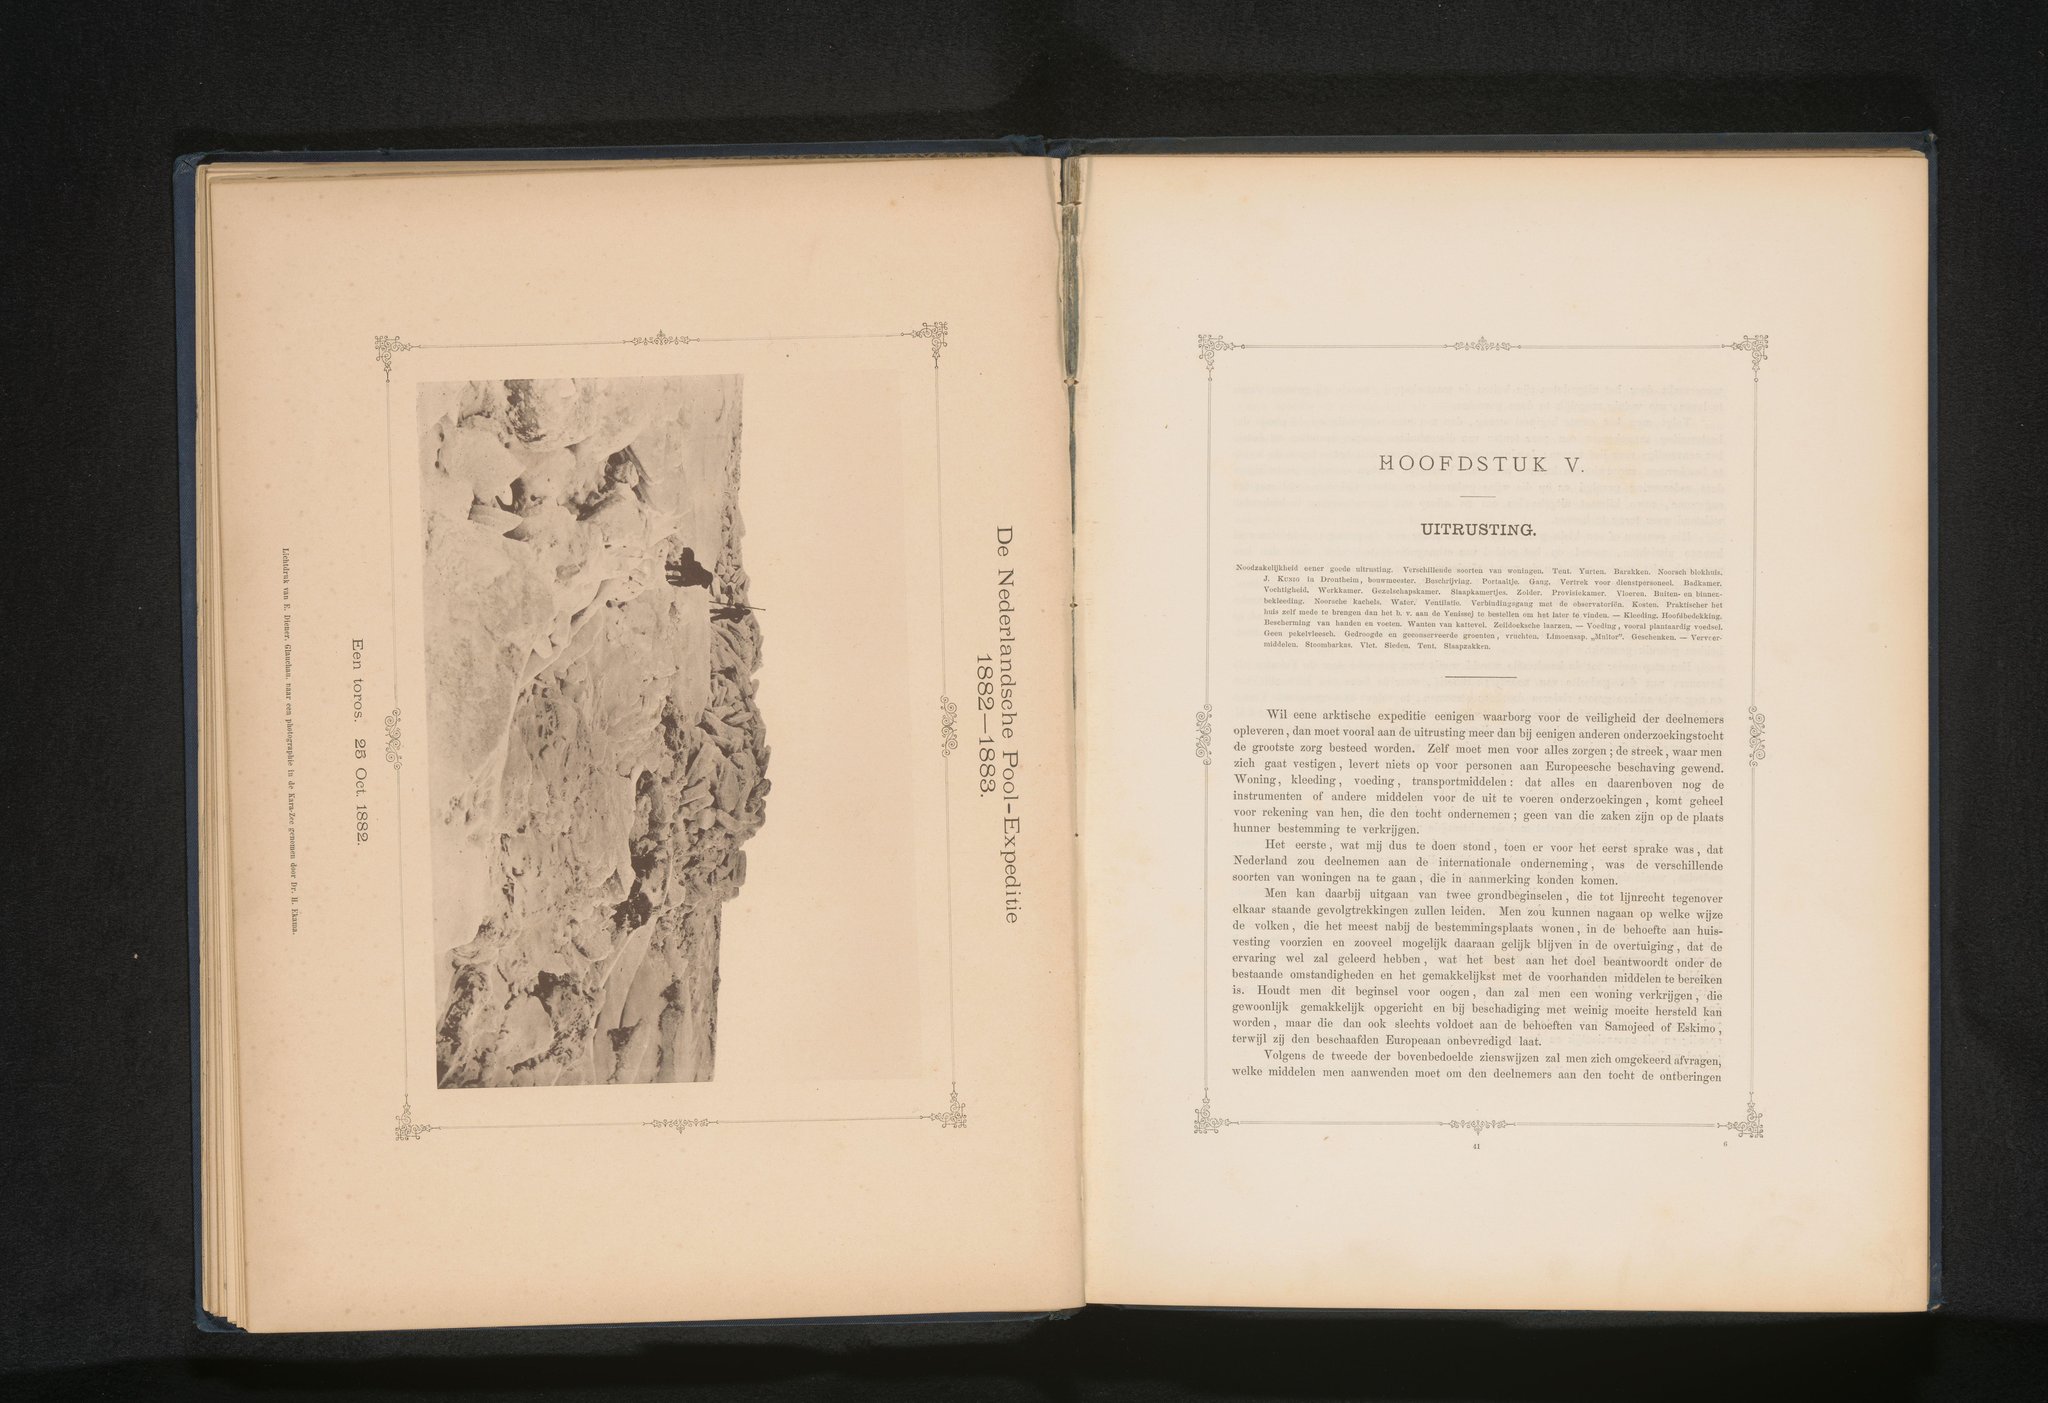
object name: photomechanical print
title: Een toros. 25 Oct. 1882.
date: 1881-1886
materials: paper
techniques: photograph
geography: glauchau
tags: iceberg, landscapes in polar regions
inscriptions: inscription: ‘De Nederlandsche Pool-Expeditie 1882-1883.’